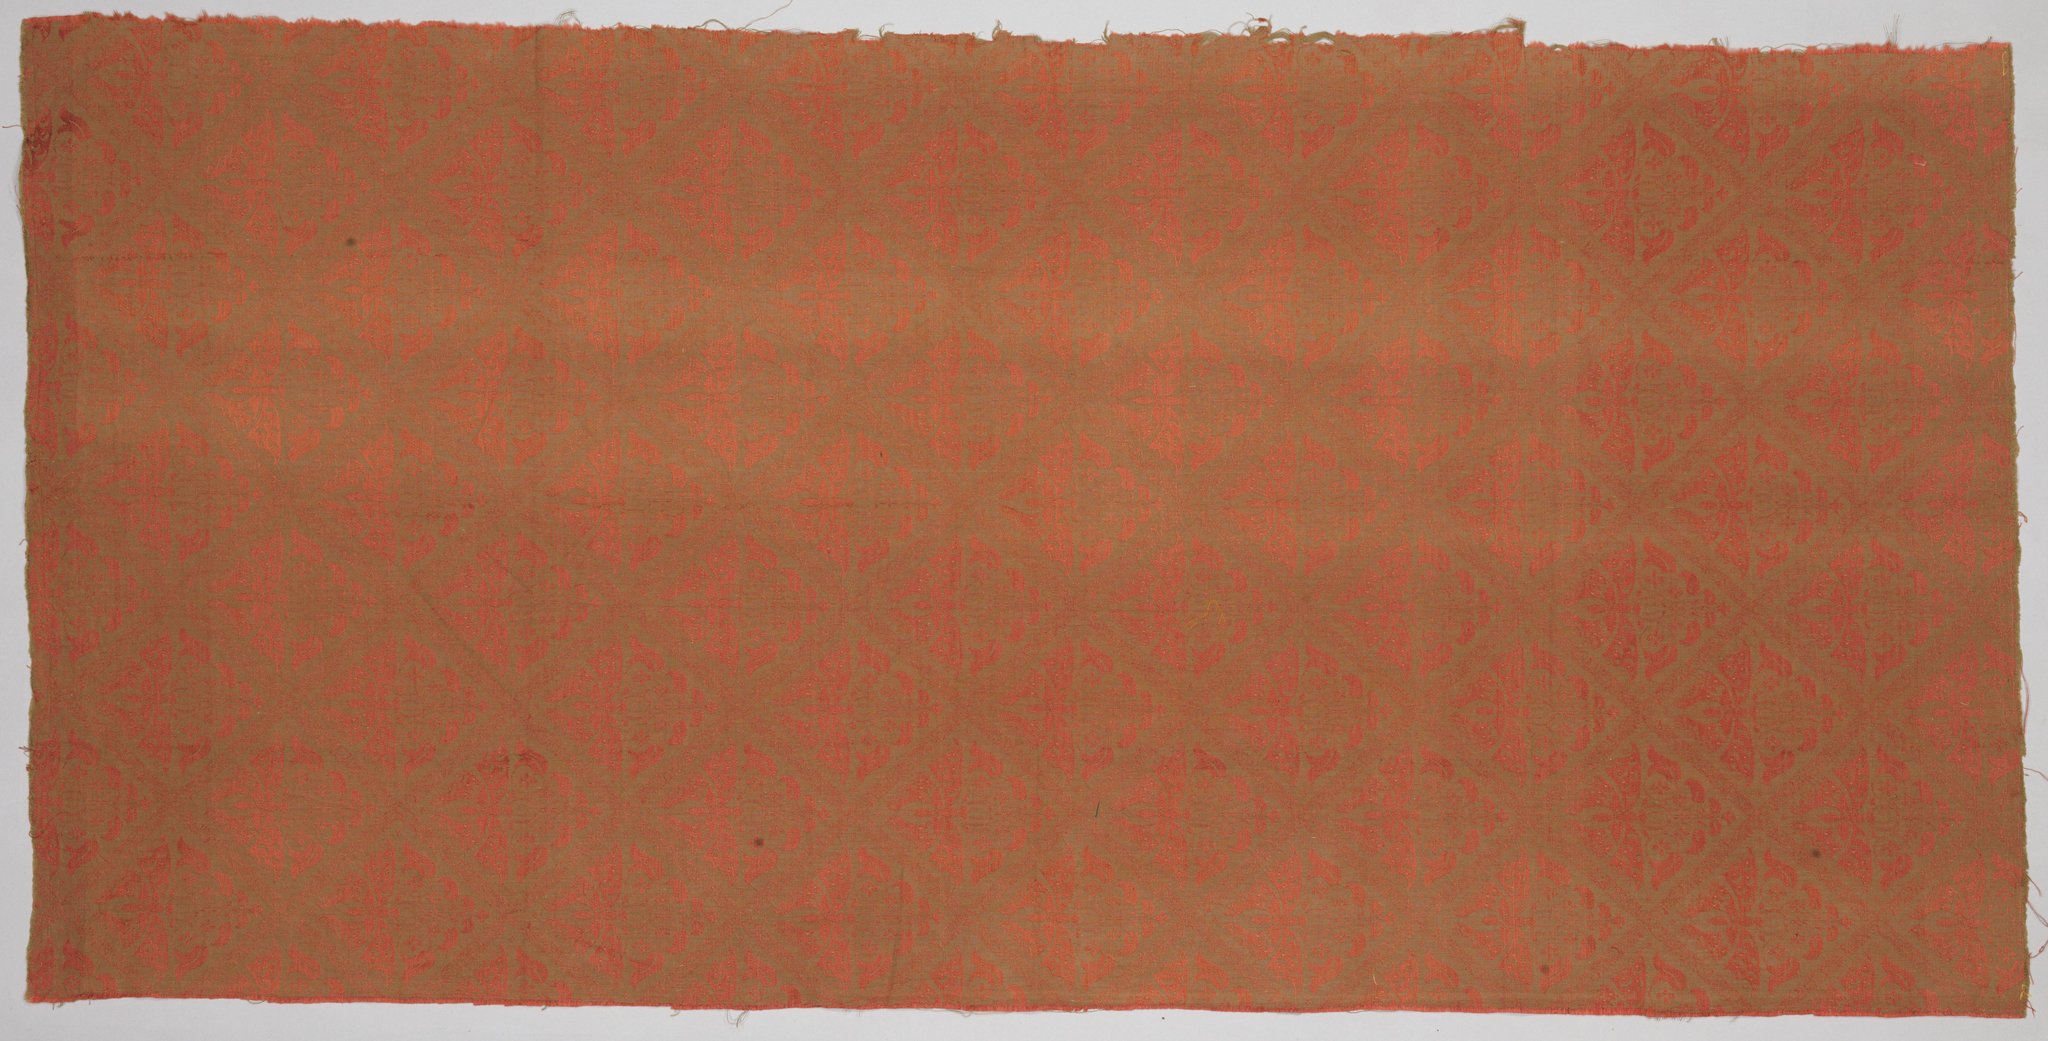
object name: curtain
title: Gordijn met vlinderpatroon in roze op beige grond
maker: theo nieuwenhuis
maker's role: designer, draughtsman, print maker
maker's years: 1866-1951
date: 1909-1924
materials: cotton, textile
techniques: weave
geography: helmond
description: Gordijn met vlinderpatroon, oud-roze op beige grond. De ondergrond is van katoen, de inweving van kunstzijde. Patroon: oneindig rapport van rasterindeling door fijne slingerende ranken met veren en spiralen. Daarbinnen telkens een vlinder met gespreide vleugels, onder een symmetrische driehoekige bloem- en bladtak.